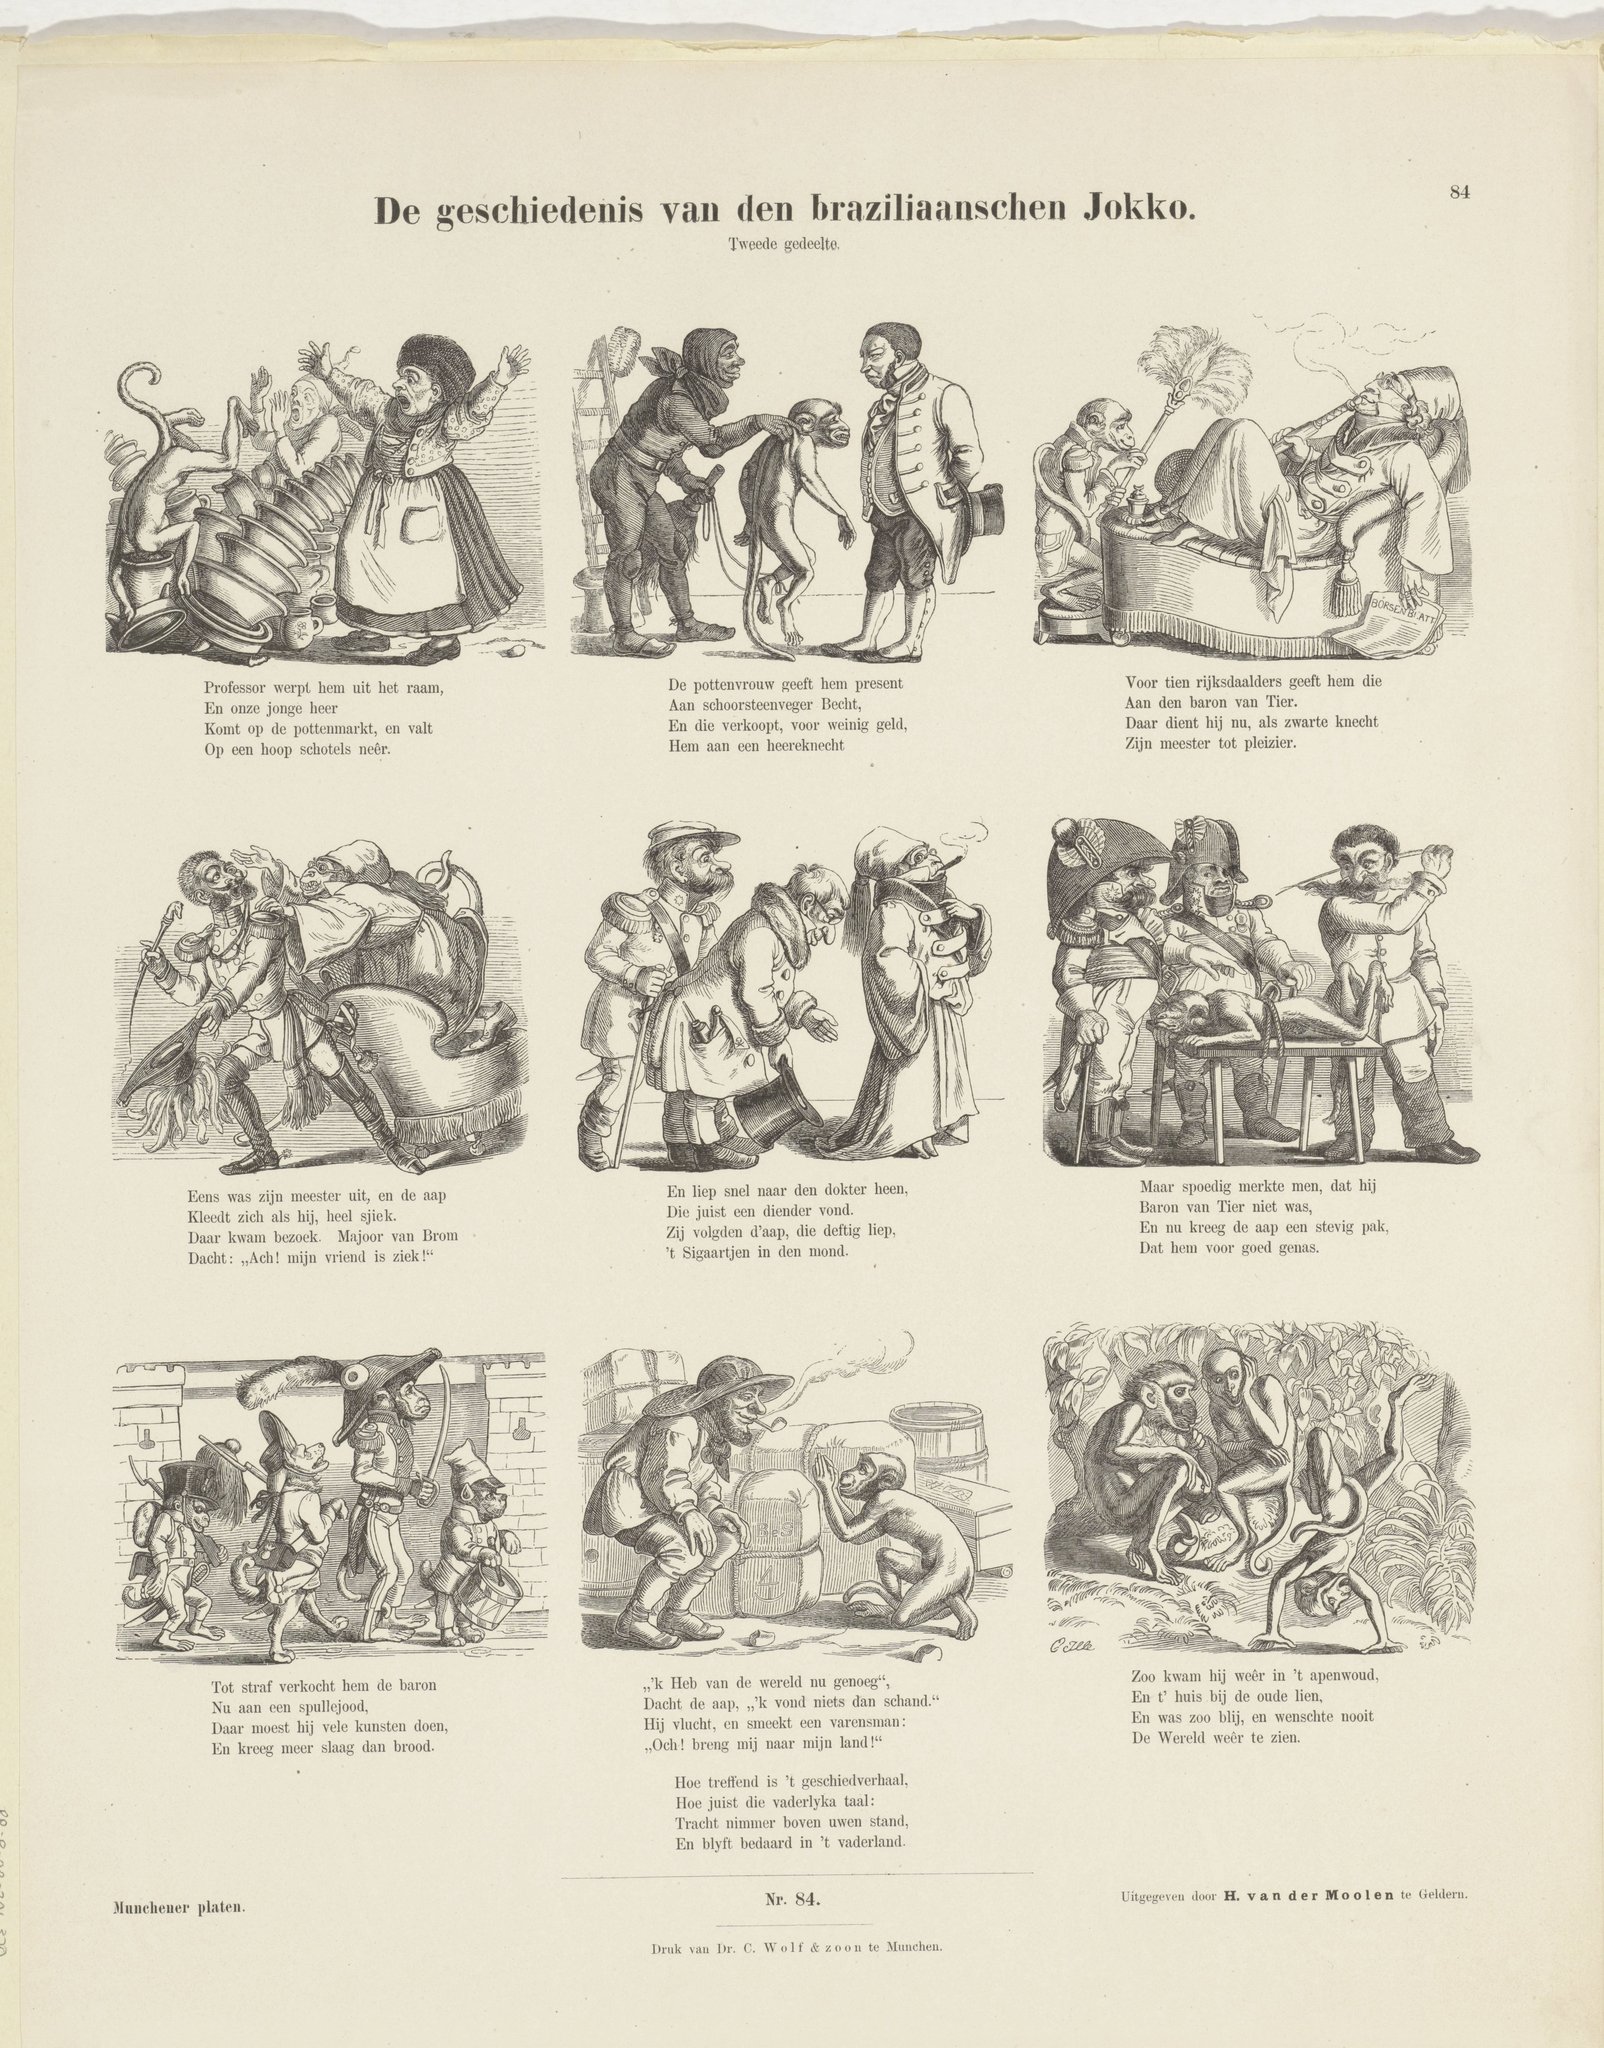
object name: popular print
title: De geschiedenis van den braziliaanschen Jokko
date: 1843-1920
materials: paper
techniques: letterpress printing, engraving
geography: germany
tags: monkeys, apes, animals acting as human beings, handicrafts ~ maintenance and repair (with name of trade or profession)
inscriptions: collector's mark: Lugt 2760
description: Blad met 9 voorstellingen over de avonturen van het Braziliaanse aapje Jokko (tweede deel). Onder elke afbeelding een vierregelig vers. Genummerd midden onder: Nro. 84. Genummerd rechtsboven: 84.